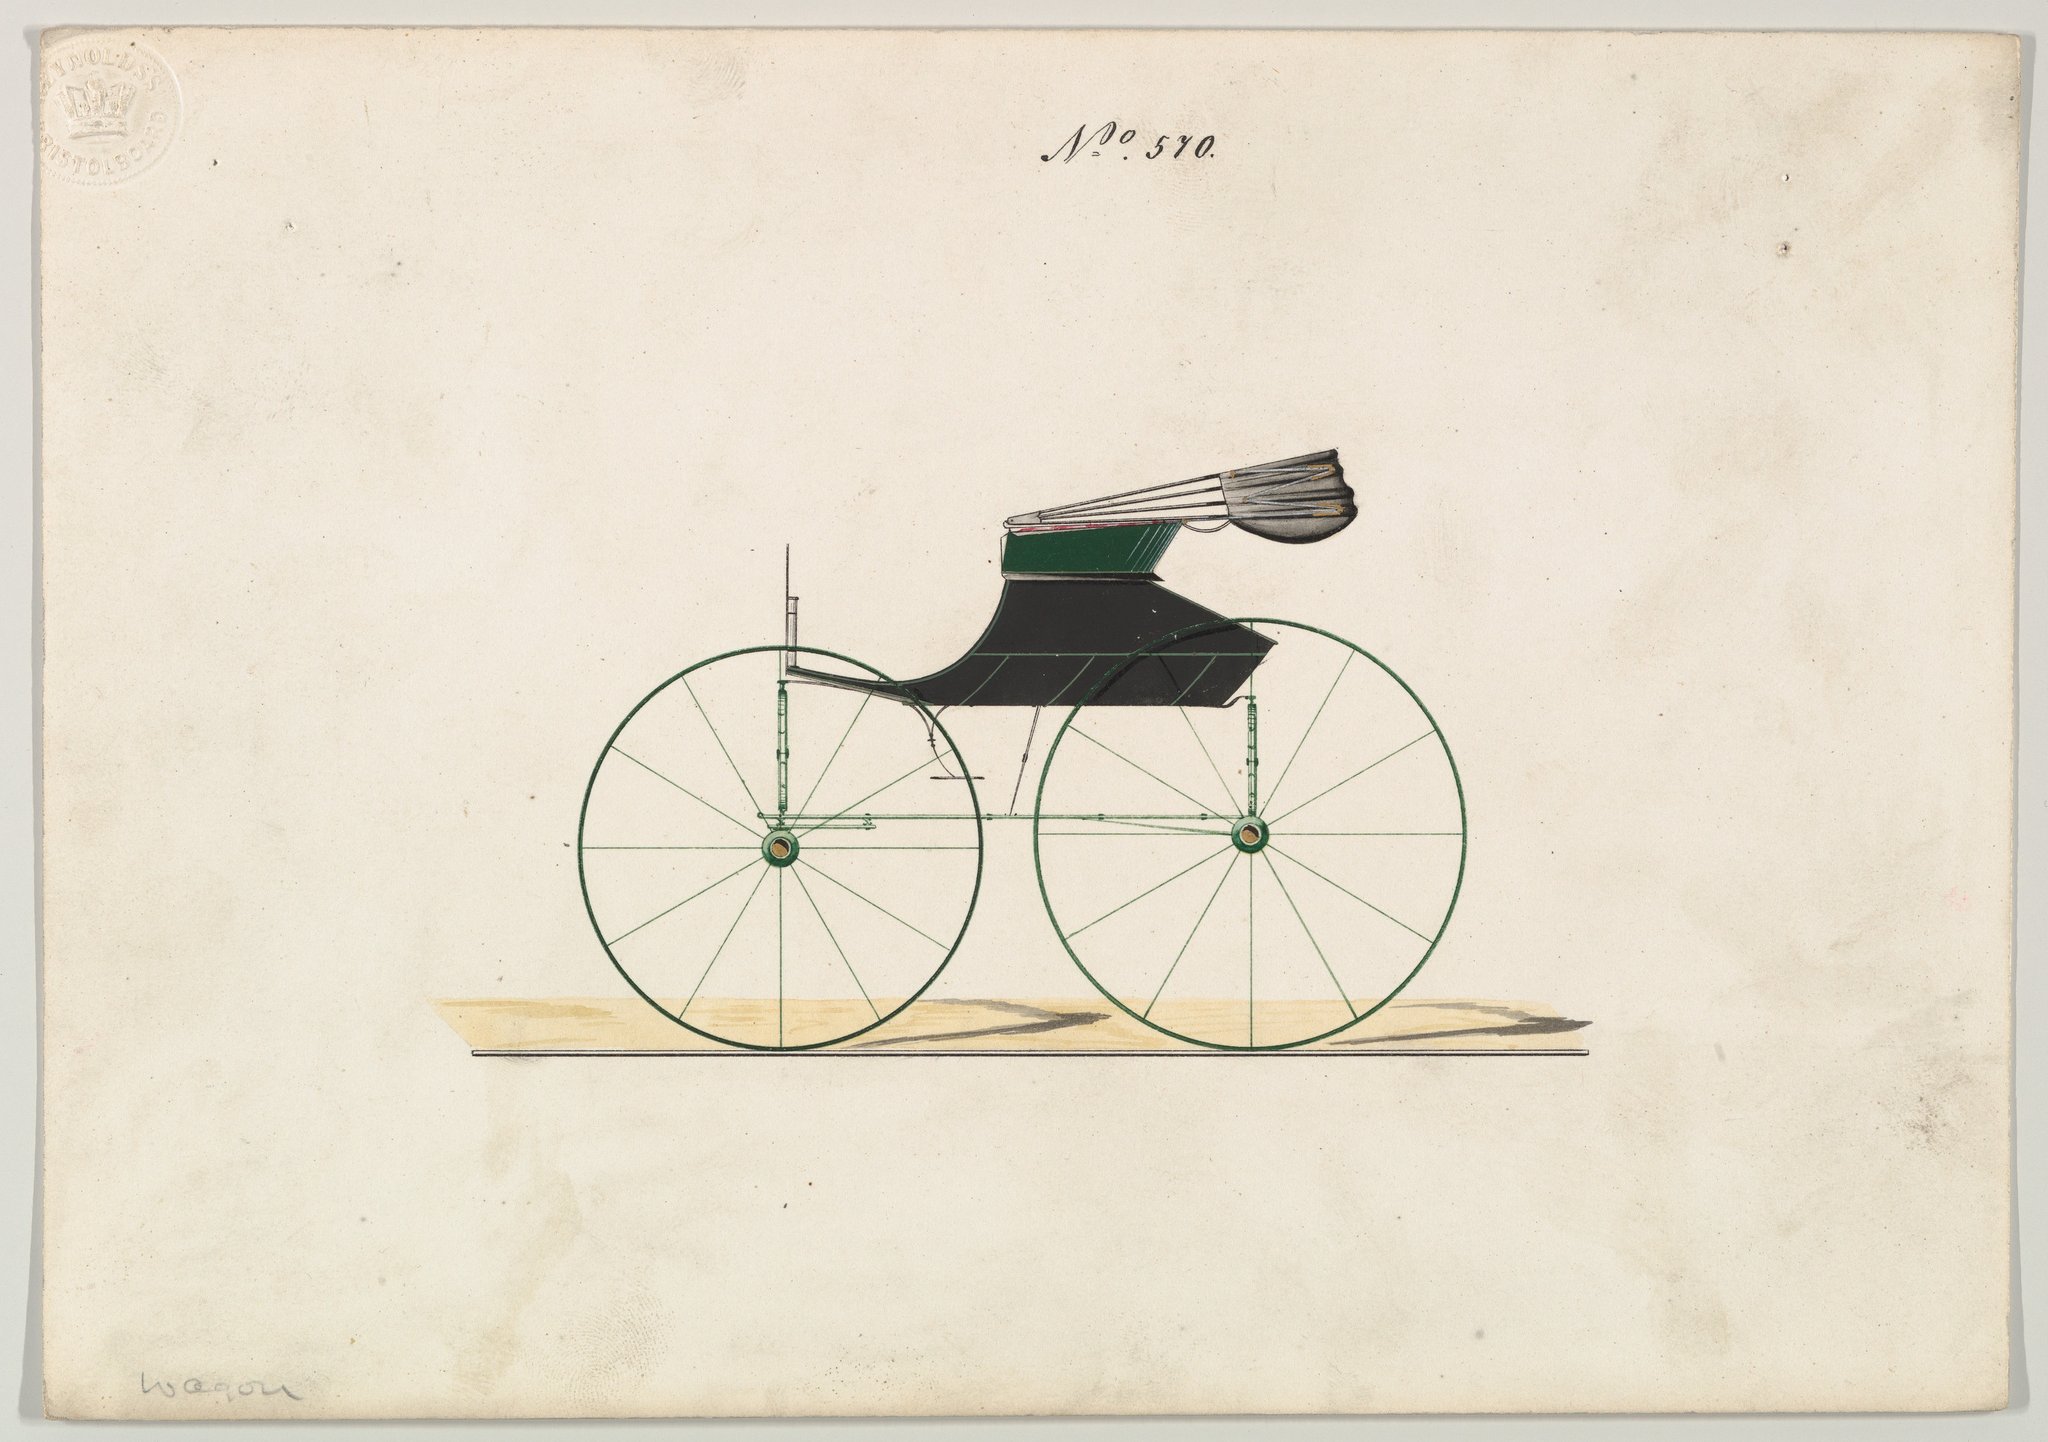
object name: drawing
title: Newport Wagon #570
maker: brewster & co.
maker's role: manufacturer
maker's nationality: american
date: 1865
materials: gouache, gum arabic, ink, watercolor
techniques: pen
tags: carriages